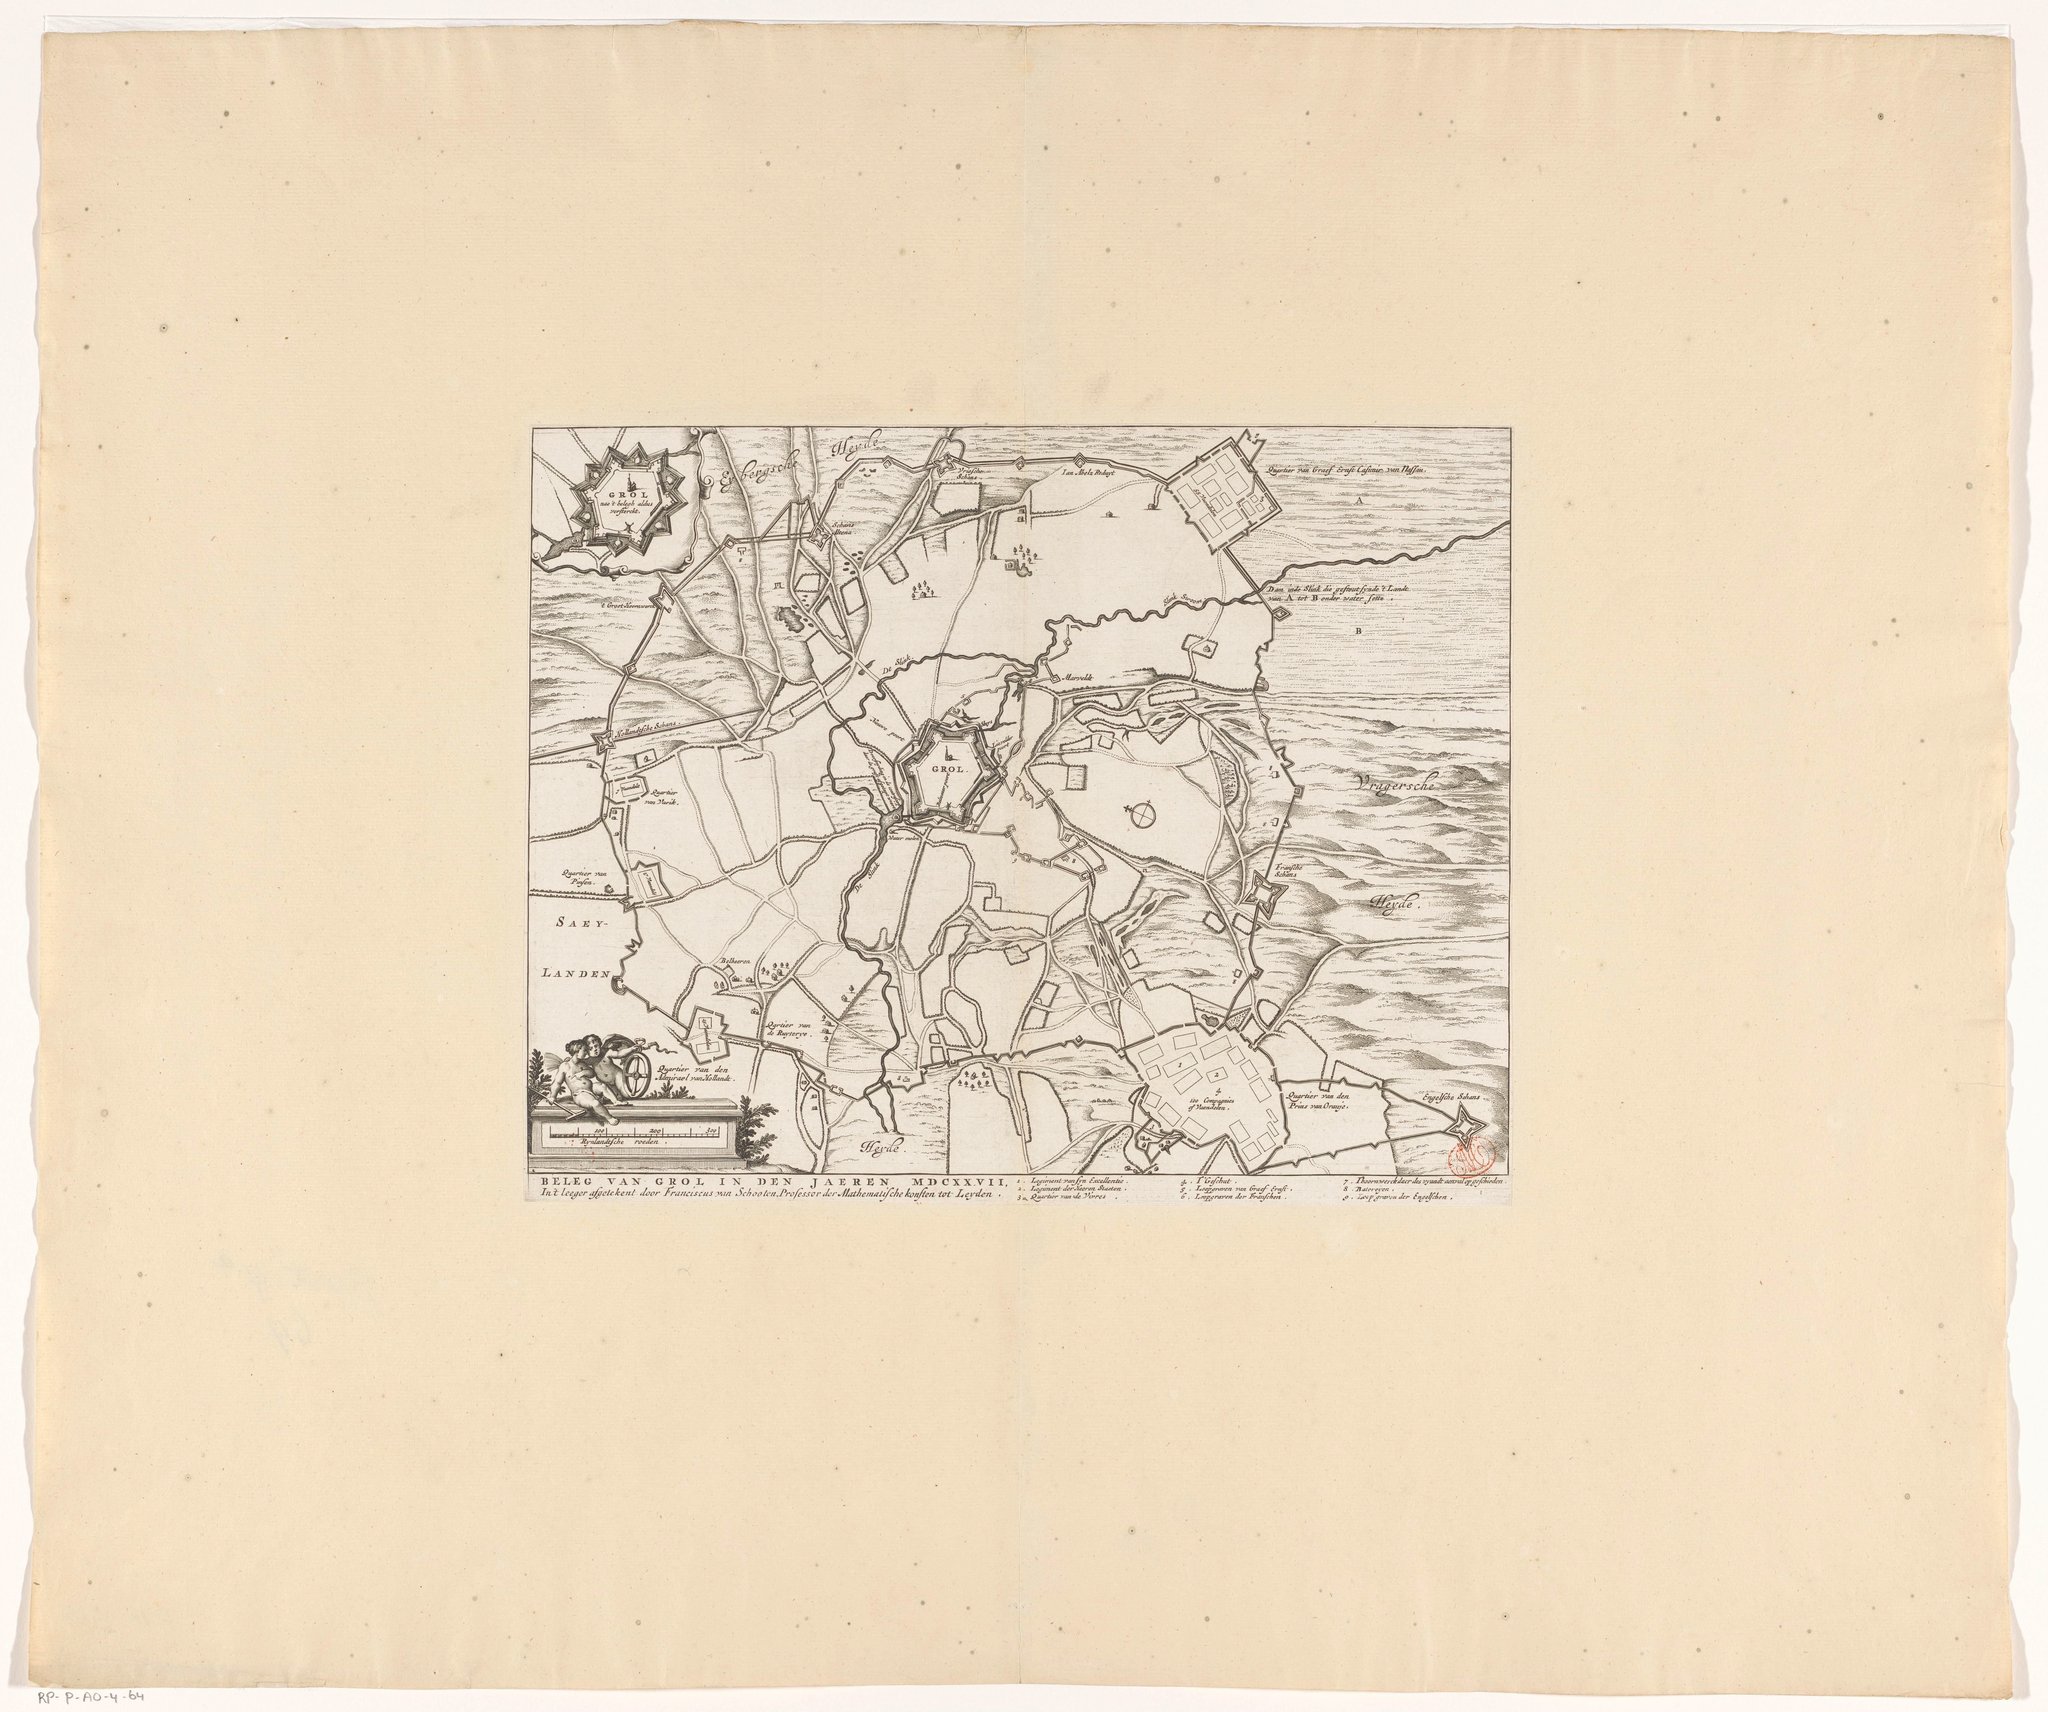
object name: history print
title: Kaart van het beleg van Groenlo, 1627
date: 1681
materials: paper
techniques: engraving, etching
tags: delft, the hague, frederick henry (prince of orange), maps of separate countries or regions, siege, position war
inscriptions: collector's mark: Lugt 195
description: Prent ook gebruikt in: Groot, Hugo de. Nederlandtsche Jaerboeken en Historien (...). Amsterdam: weduwe Joannes van Someren, Abraham Wolfgang en Hendrick en Dirk Boom, 1681. Kopie naar de prent gebruikt in: Blaeu, Johannes Willemszoon. Novum ac magnum theatrum urbium Belgicae (...). 2 delen. 1e druk. Amsterdam: Johannes Willemszoon Blaeu, 1649, dl. 1. Wellicht uit hetzelfde werk als FMH 1573.